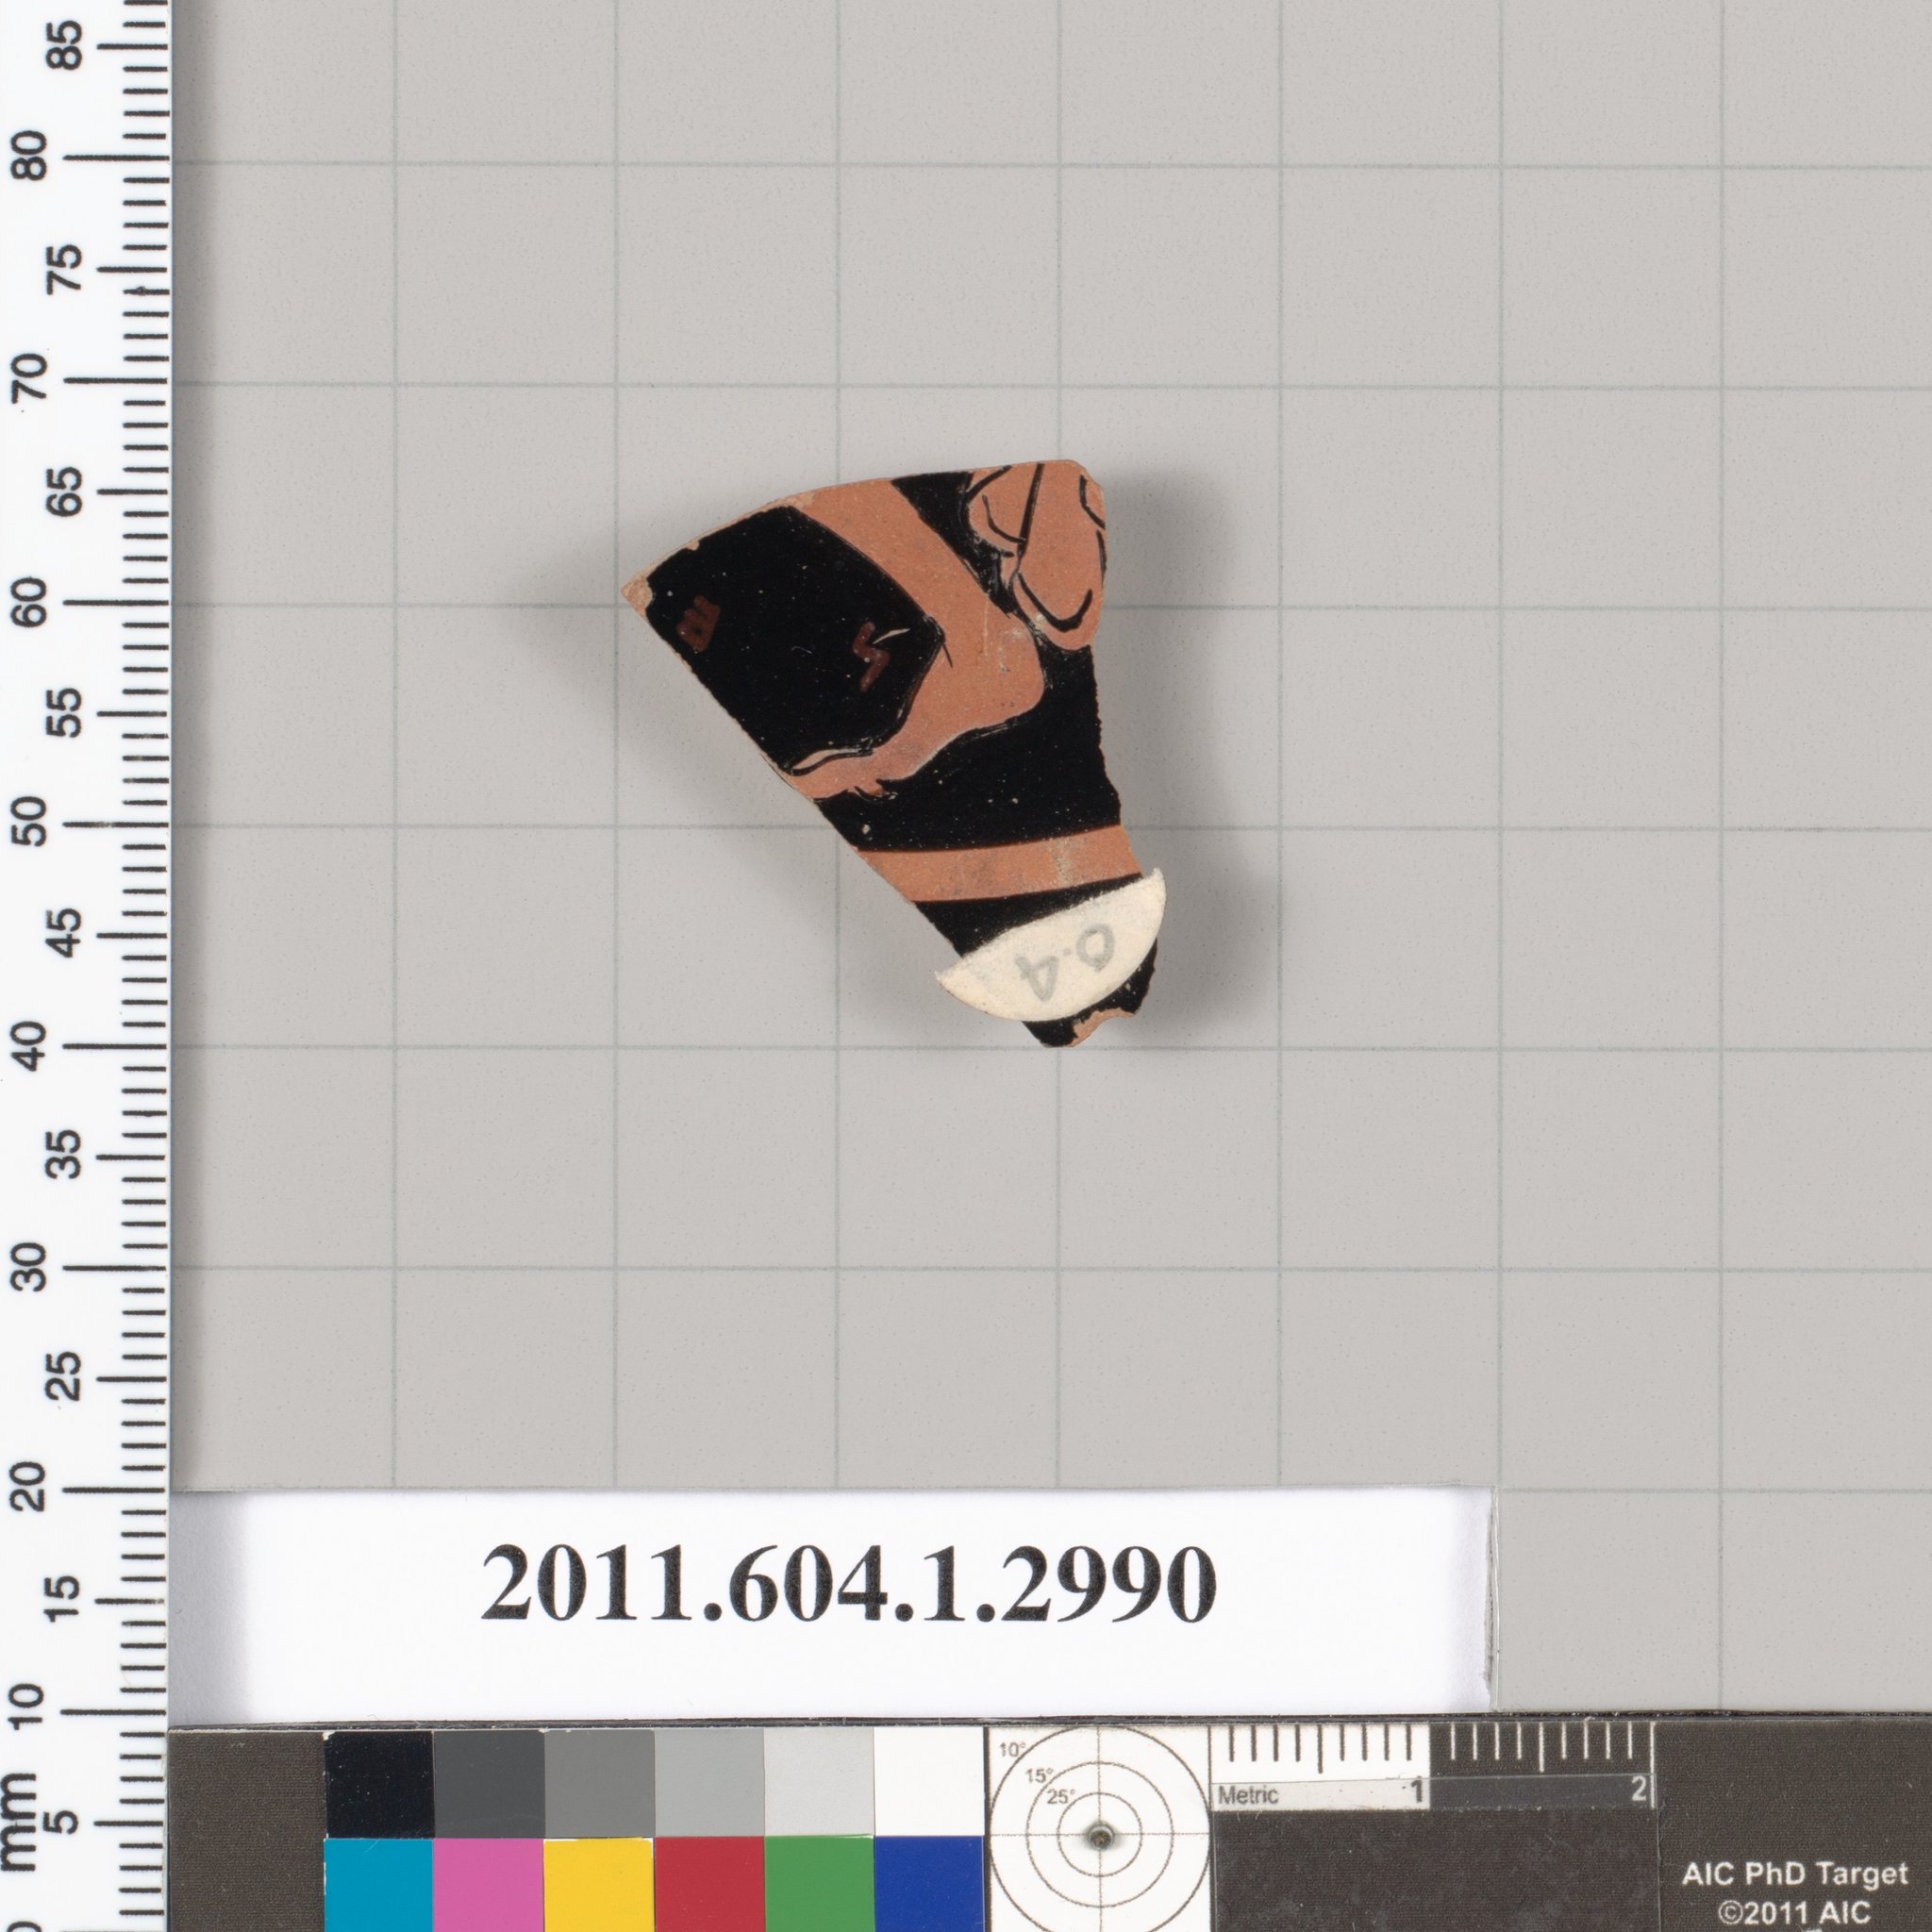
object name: kylix fragment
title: Terracotta fragment of a kylix (drinking cup)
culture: greek, attic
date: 500-490 BCE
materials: terracotta